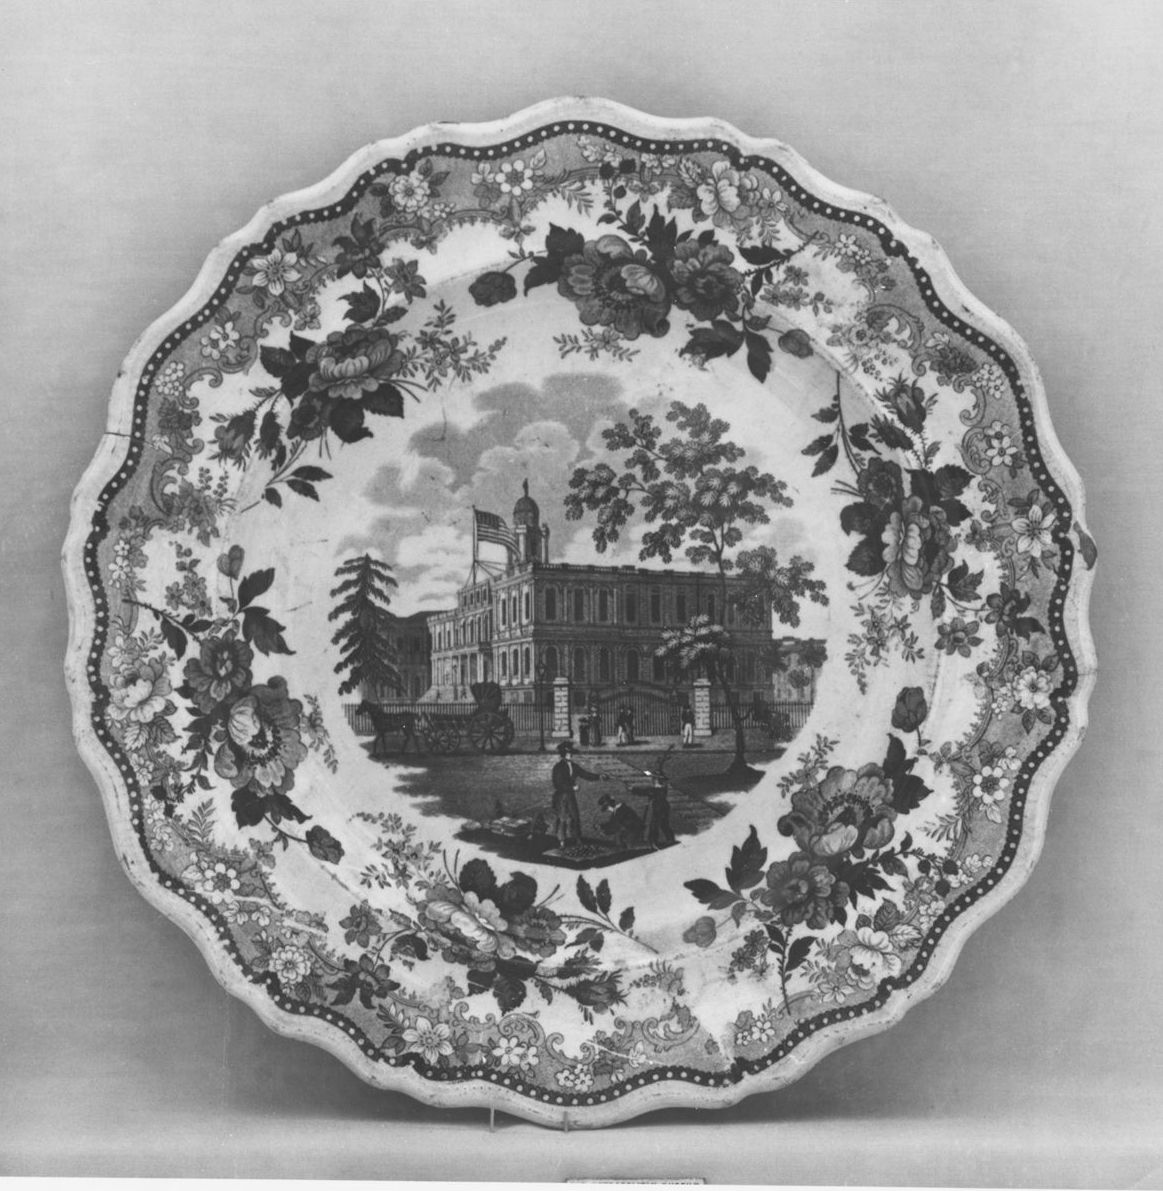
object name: plate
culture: british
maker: job & john jackson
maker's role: maker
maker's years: 1831-1835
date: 1831-1835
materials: earthenware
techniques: transfer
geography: england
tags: buildings,flowers